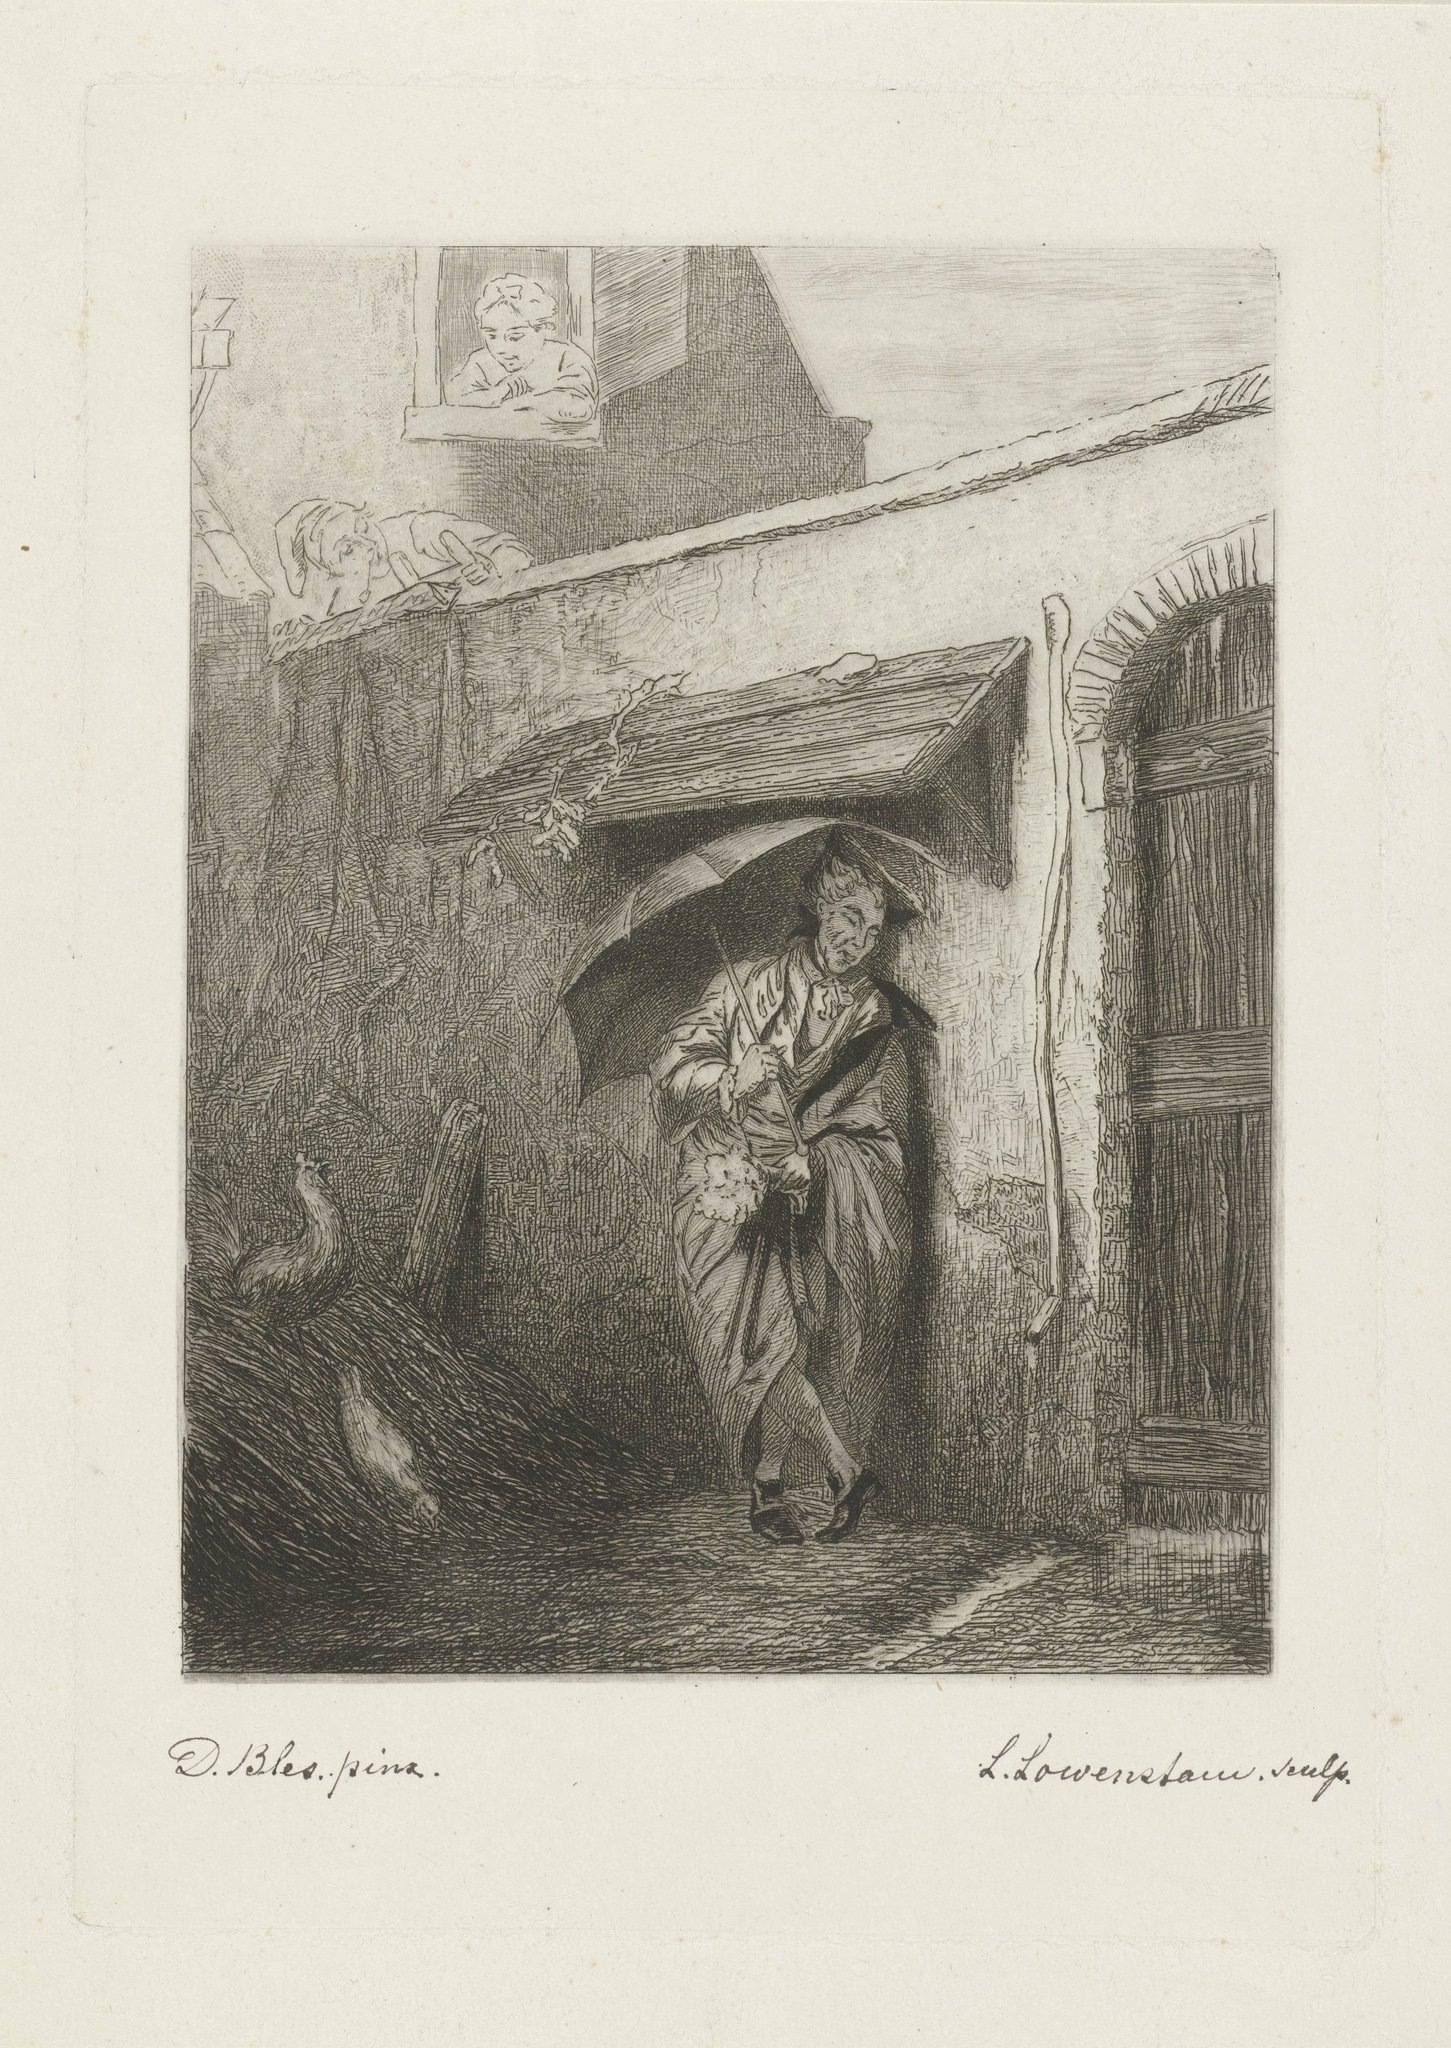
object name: print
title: Man met bloemen bij een poortje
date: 1852-1898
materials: paper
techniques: etching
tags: one lover waiting for the other (+ variant), cut flowers; nosegay, bunch of flowers, umbrella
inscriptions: collector's mark: Lugt 2228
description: Een man wacht onder een paraplu bij een poortje met een bos bloemen in zijn hand. Op de achtergrond kijken twee figuren nieuwsgierig toe.